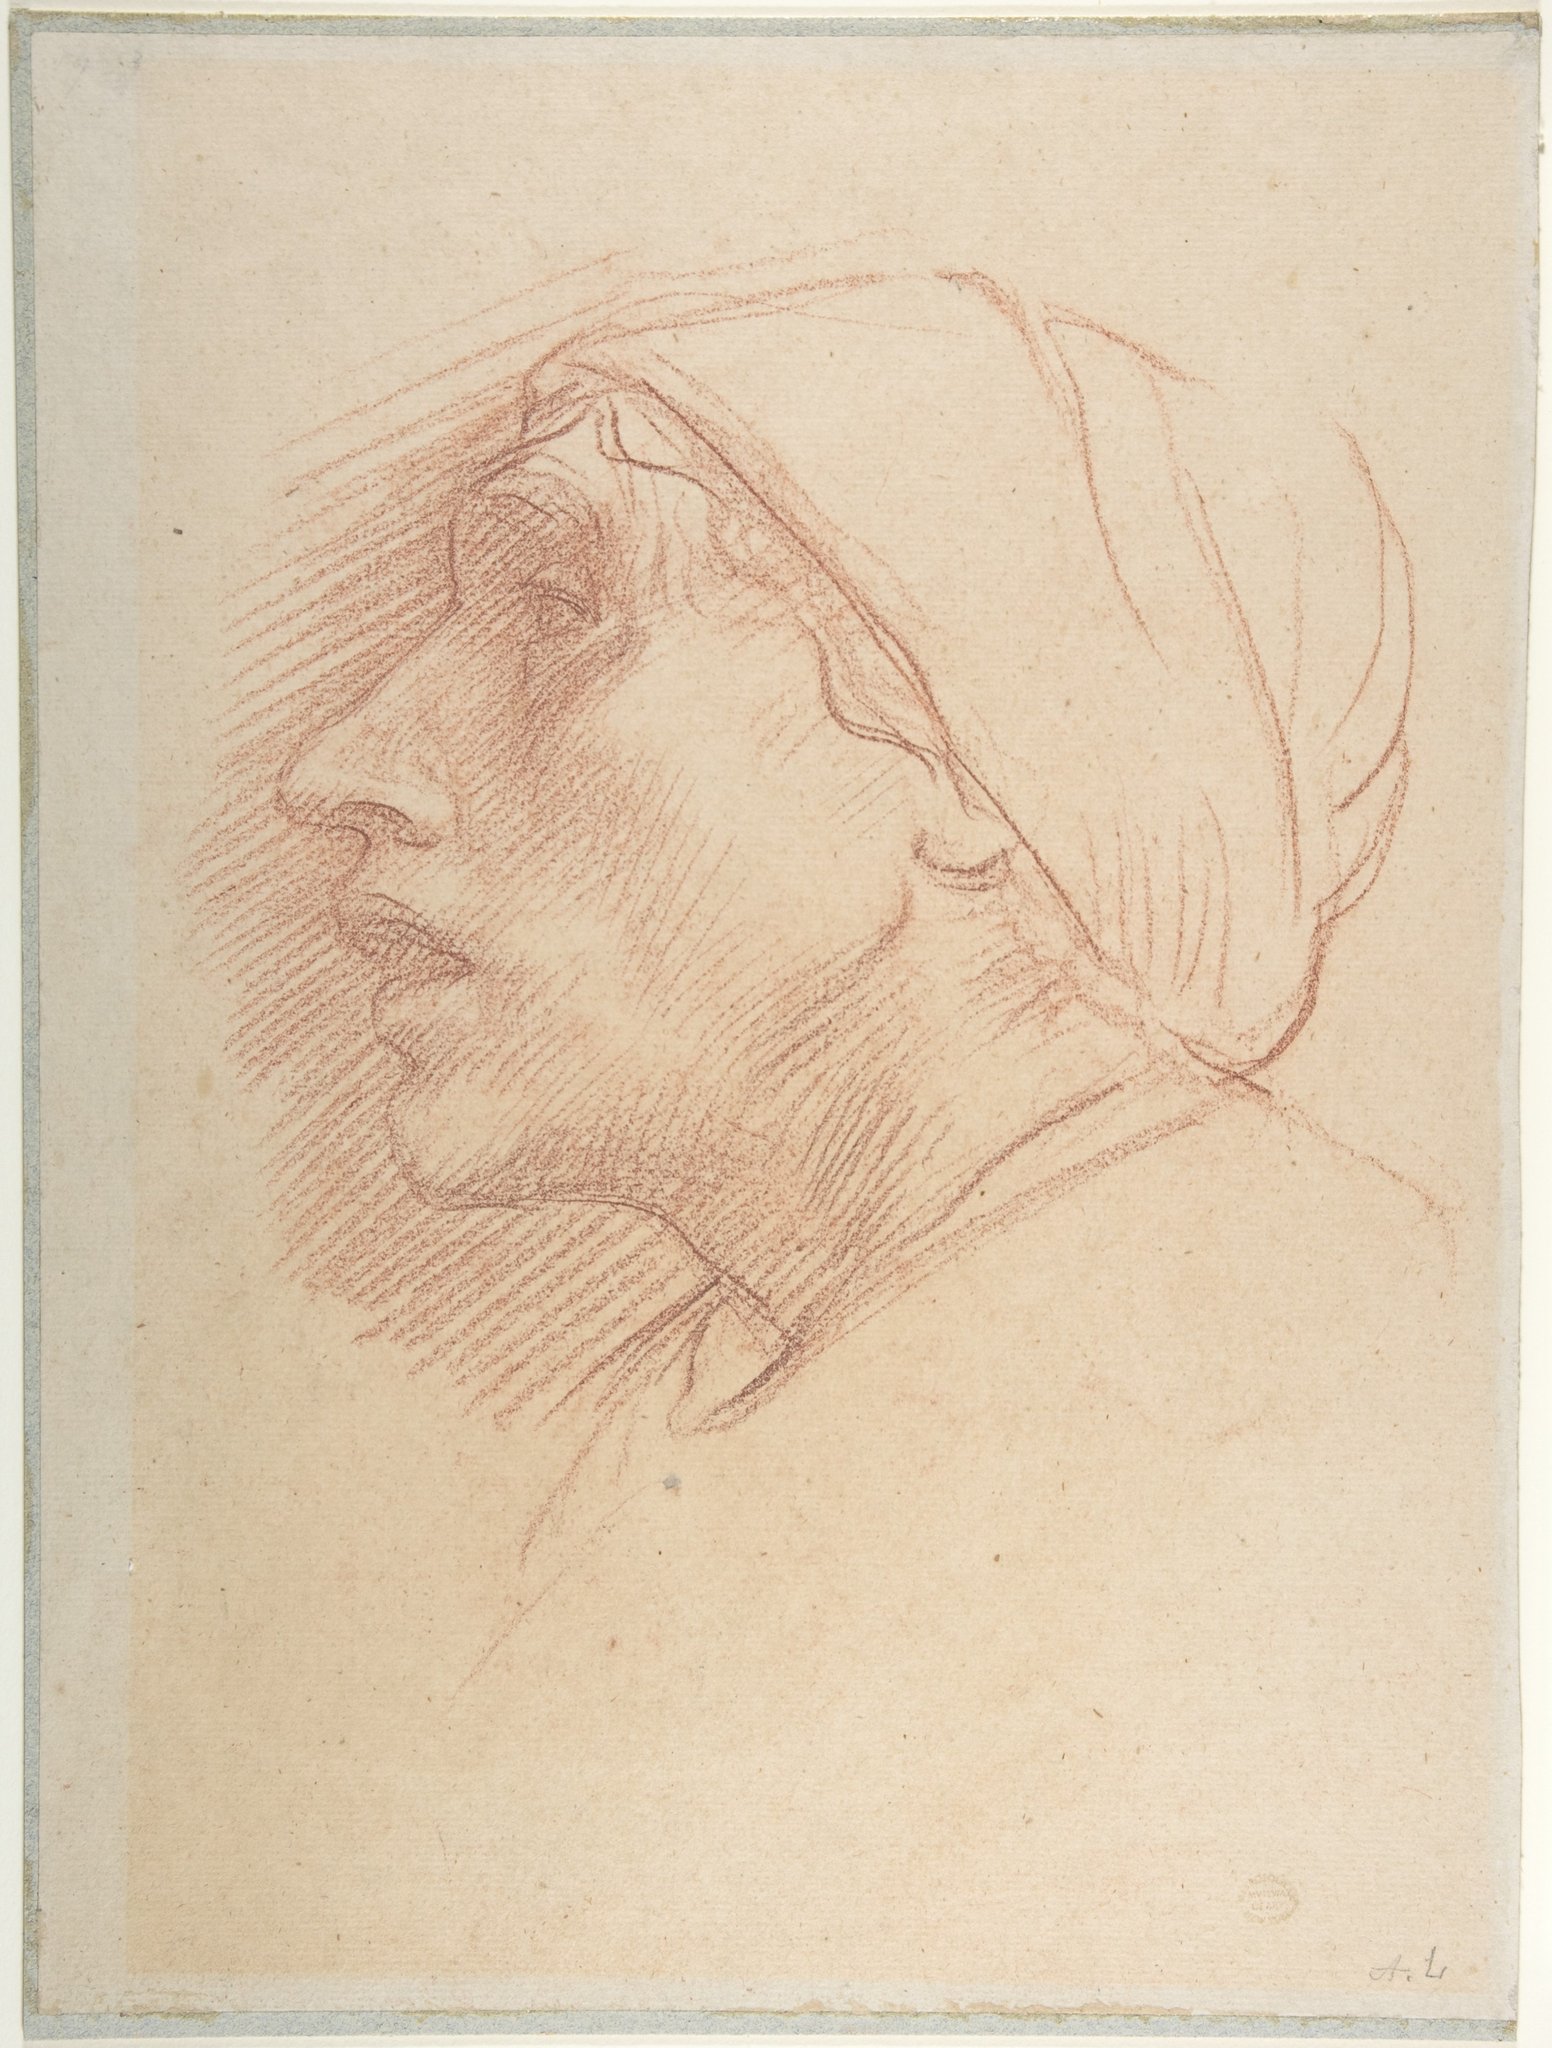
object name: drawing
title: Head of a Woman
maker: alphonse legros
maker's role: artist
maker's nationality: french and british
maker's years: 1837-1911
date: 1837-1911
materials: chalk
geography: france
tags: heads,profiles,women